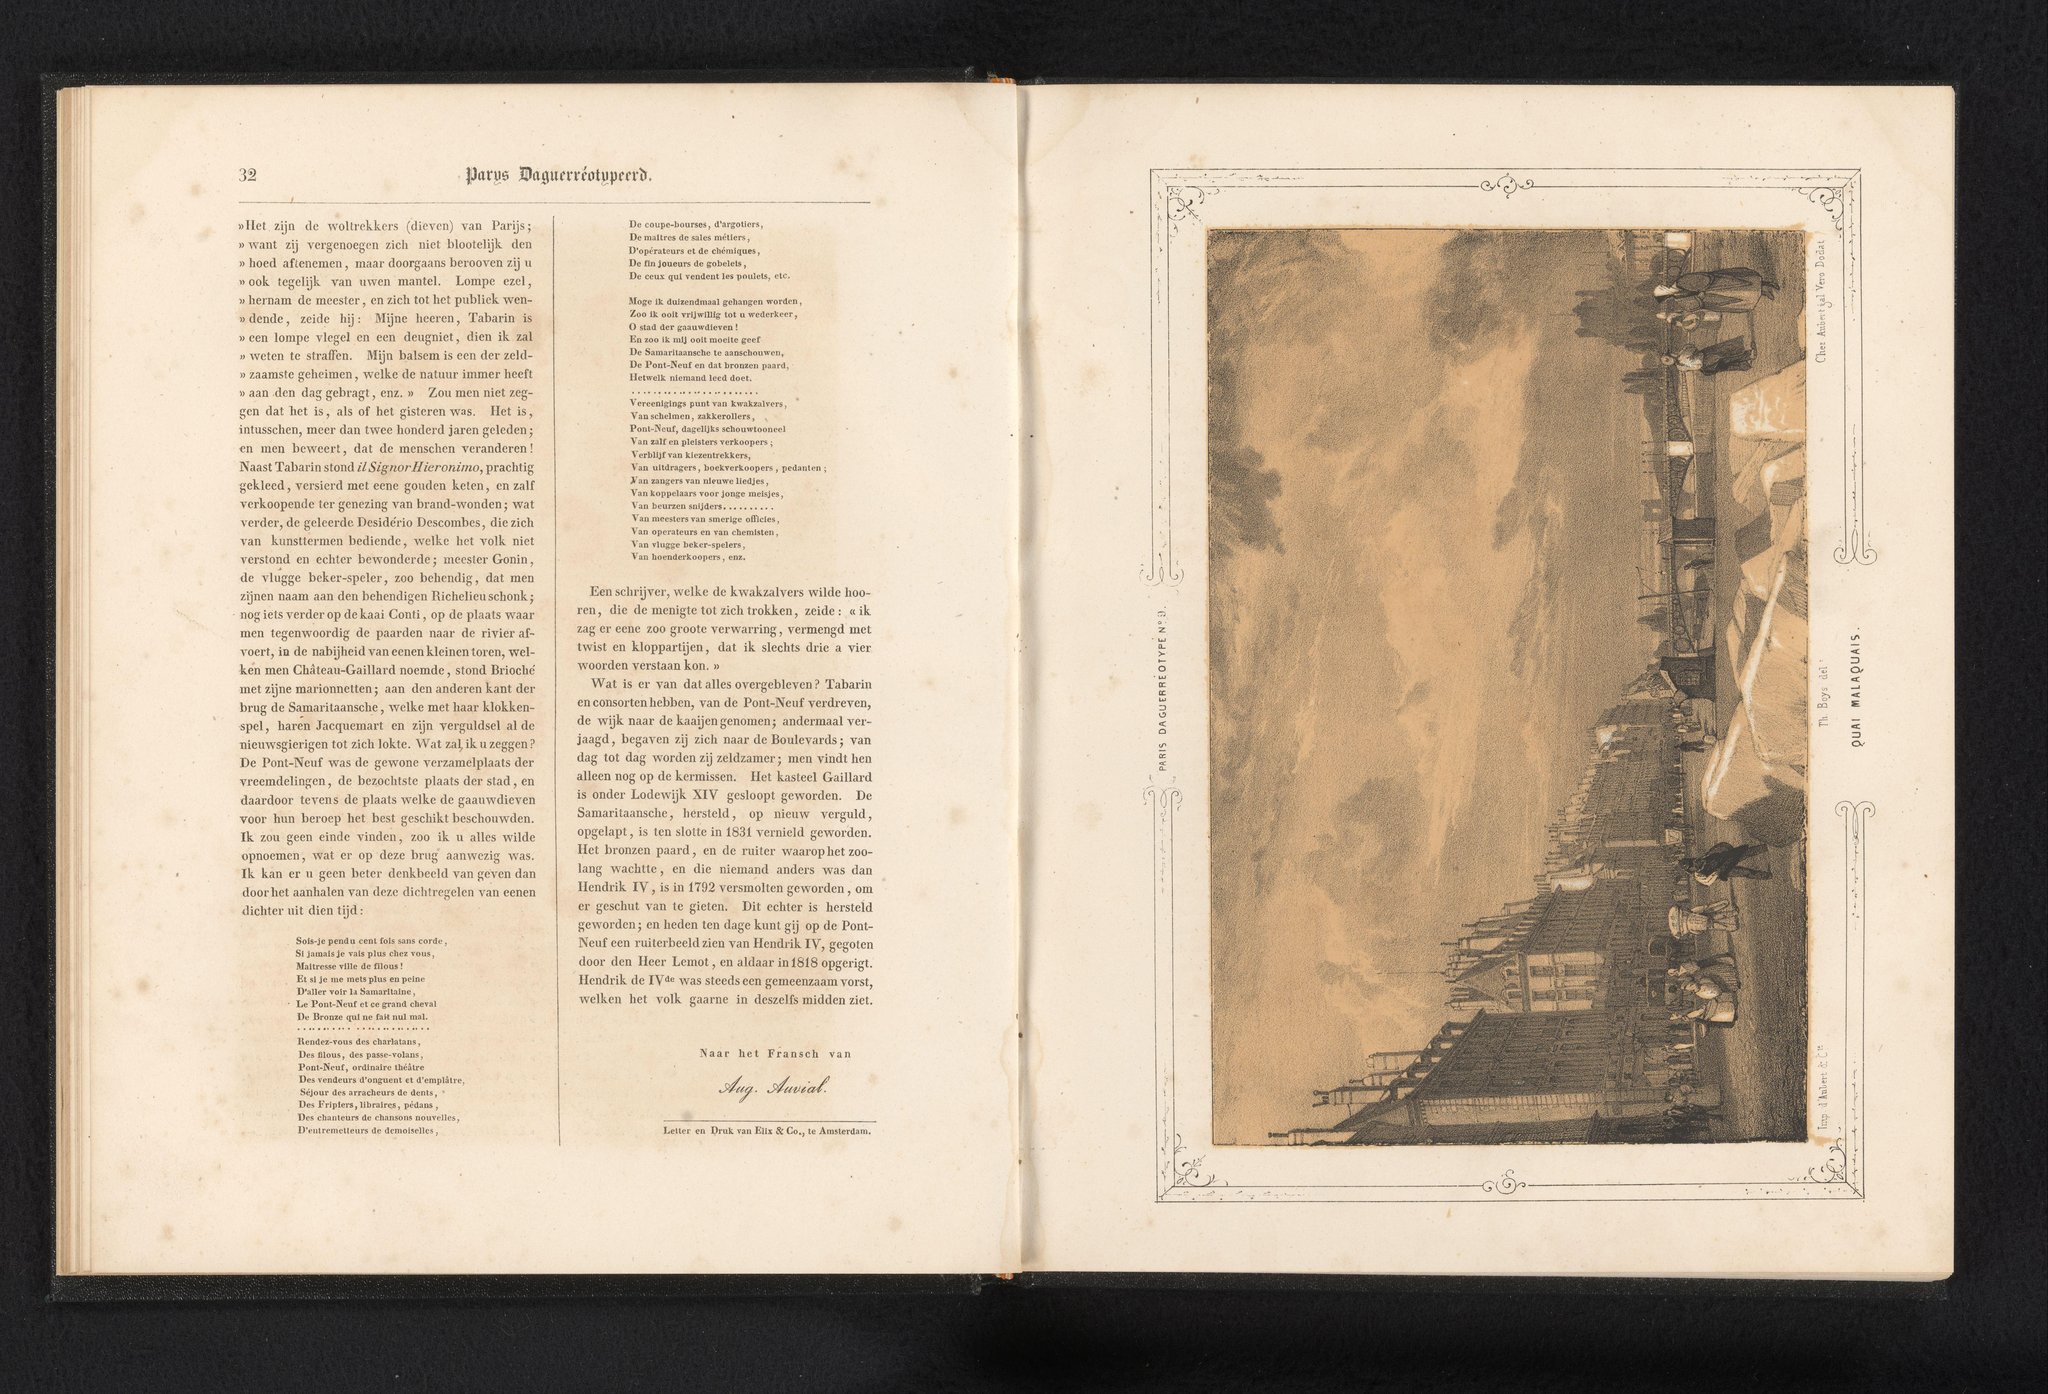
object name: print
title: Quai Malaquais in Parijs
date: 1839-1840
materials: paper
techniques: tone lithography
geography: paris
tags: quay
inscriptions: inscription: ‘PARIS DAGUERRÉOTYPÉ No. 9.’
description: Prent op drieëndertigste ongenummerde pagina.